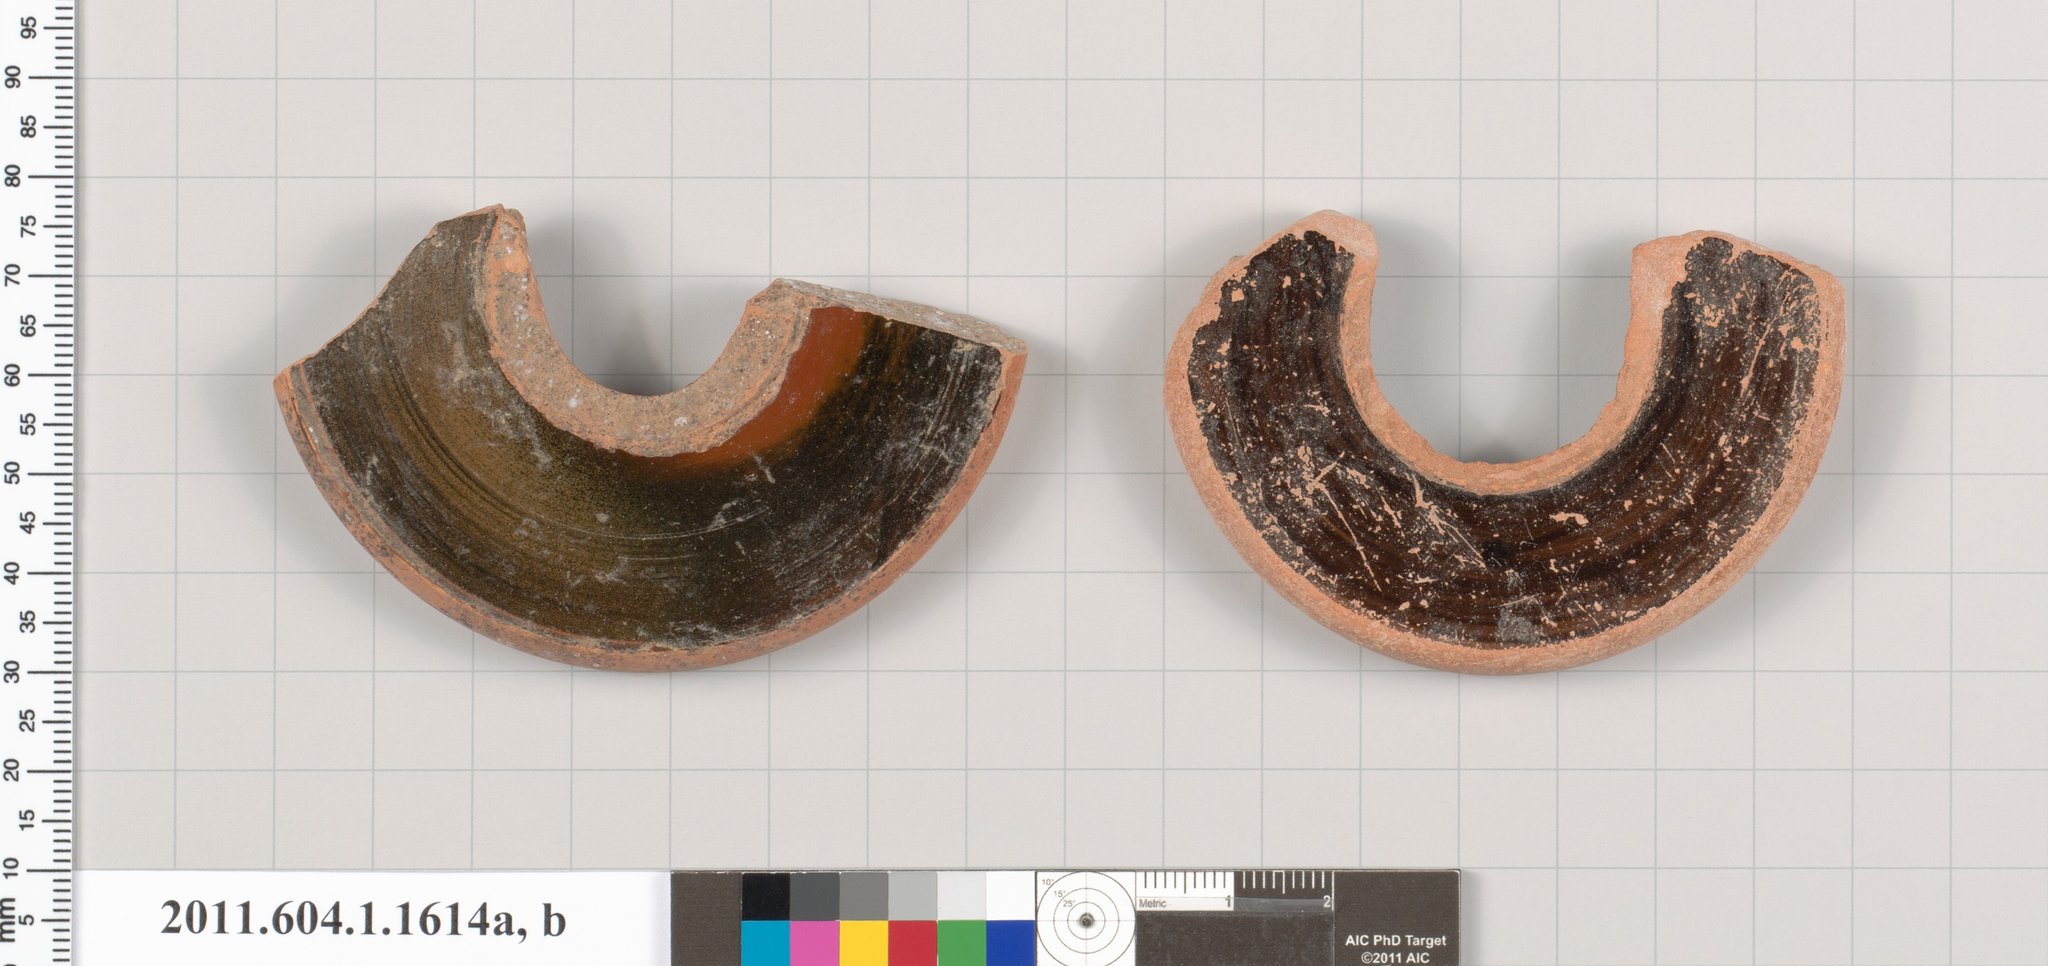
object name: kylix fragment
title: Terracotta fragments of kylikes (drinking cups)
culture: greek, attic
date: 500-401 BCE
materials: terracotta